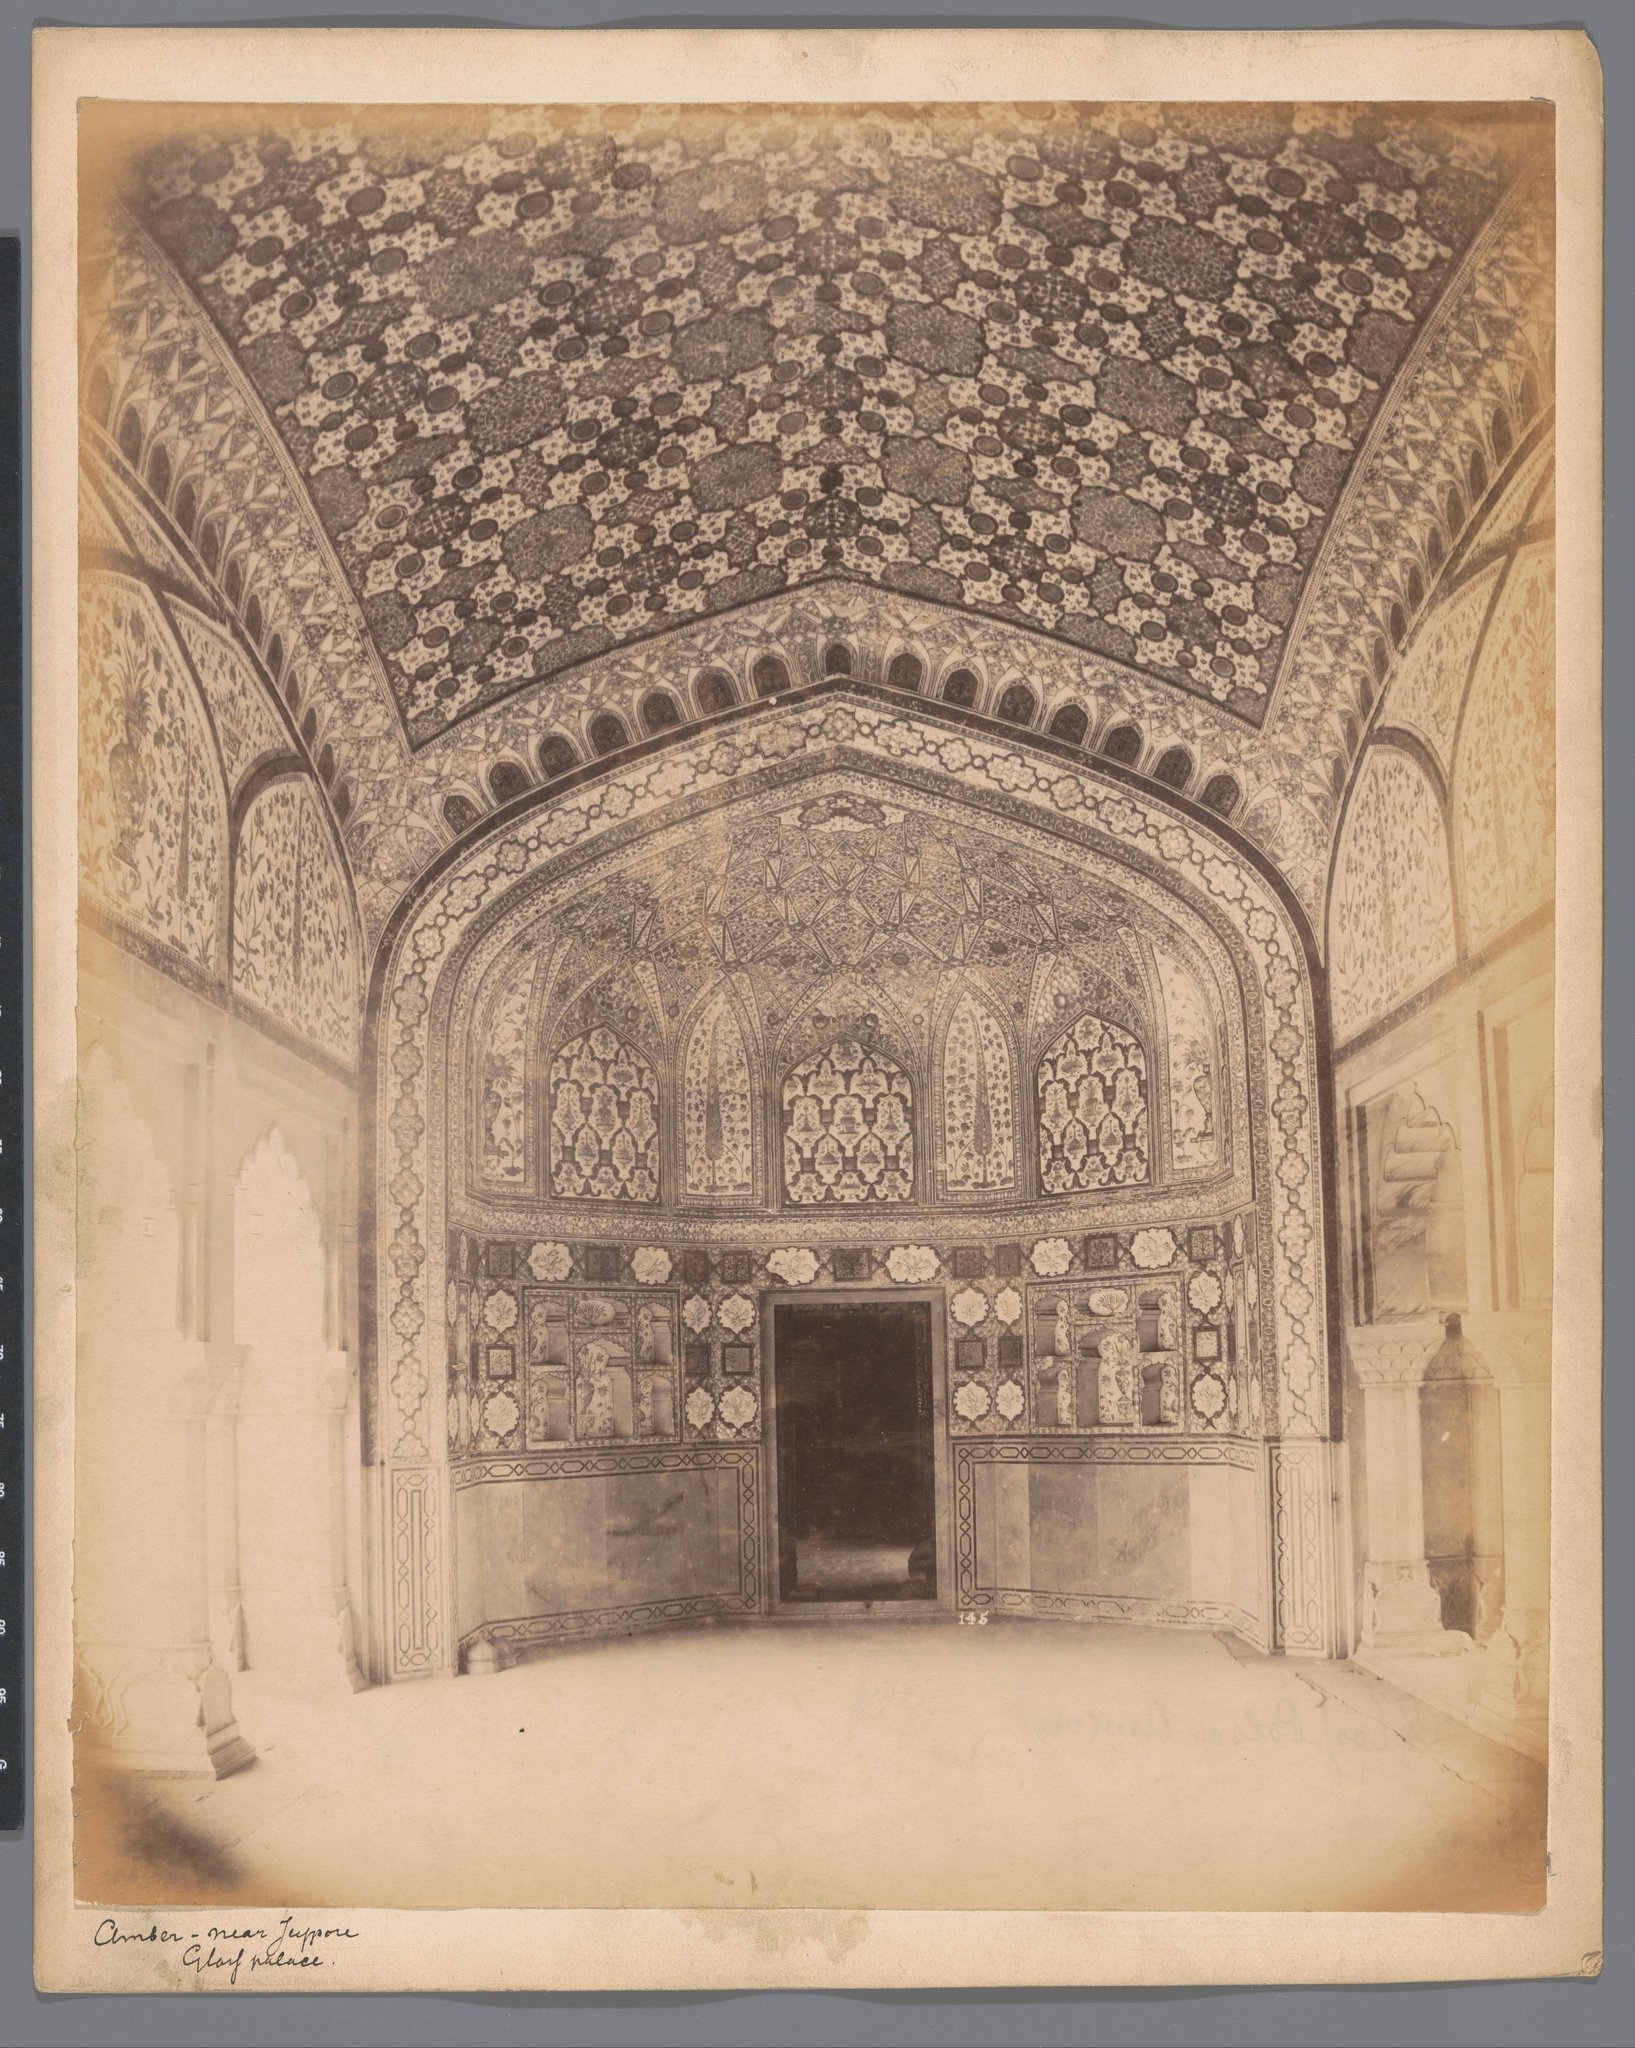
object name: photograph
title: Interior of the Sheesh Mahal in Amer Fort near Jaipur, Rajasthan, India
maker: Anonymous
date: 1865-1890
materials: cardboard, paper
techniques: albumen print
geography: amer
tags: palace, (decorated) ceiling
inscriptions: number: ‘145’, title, r: ‘Amber - near Jeypore/ Glass palace.’, number: ‘91’